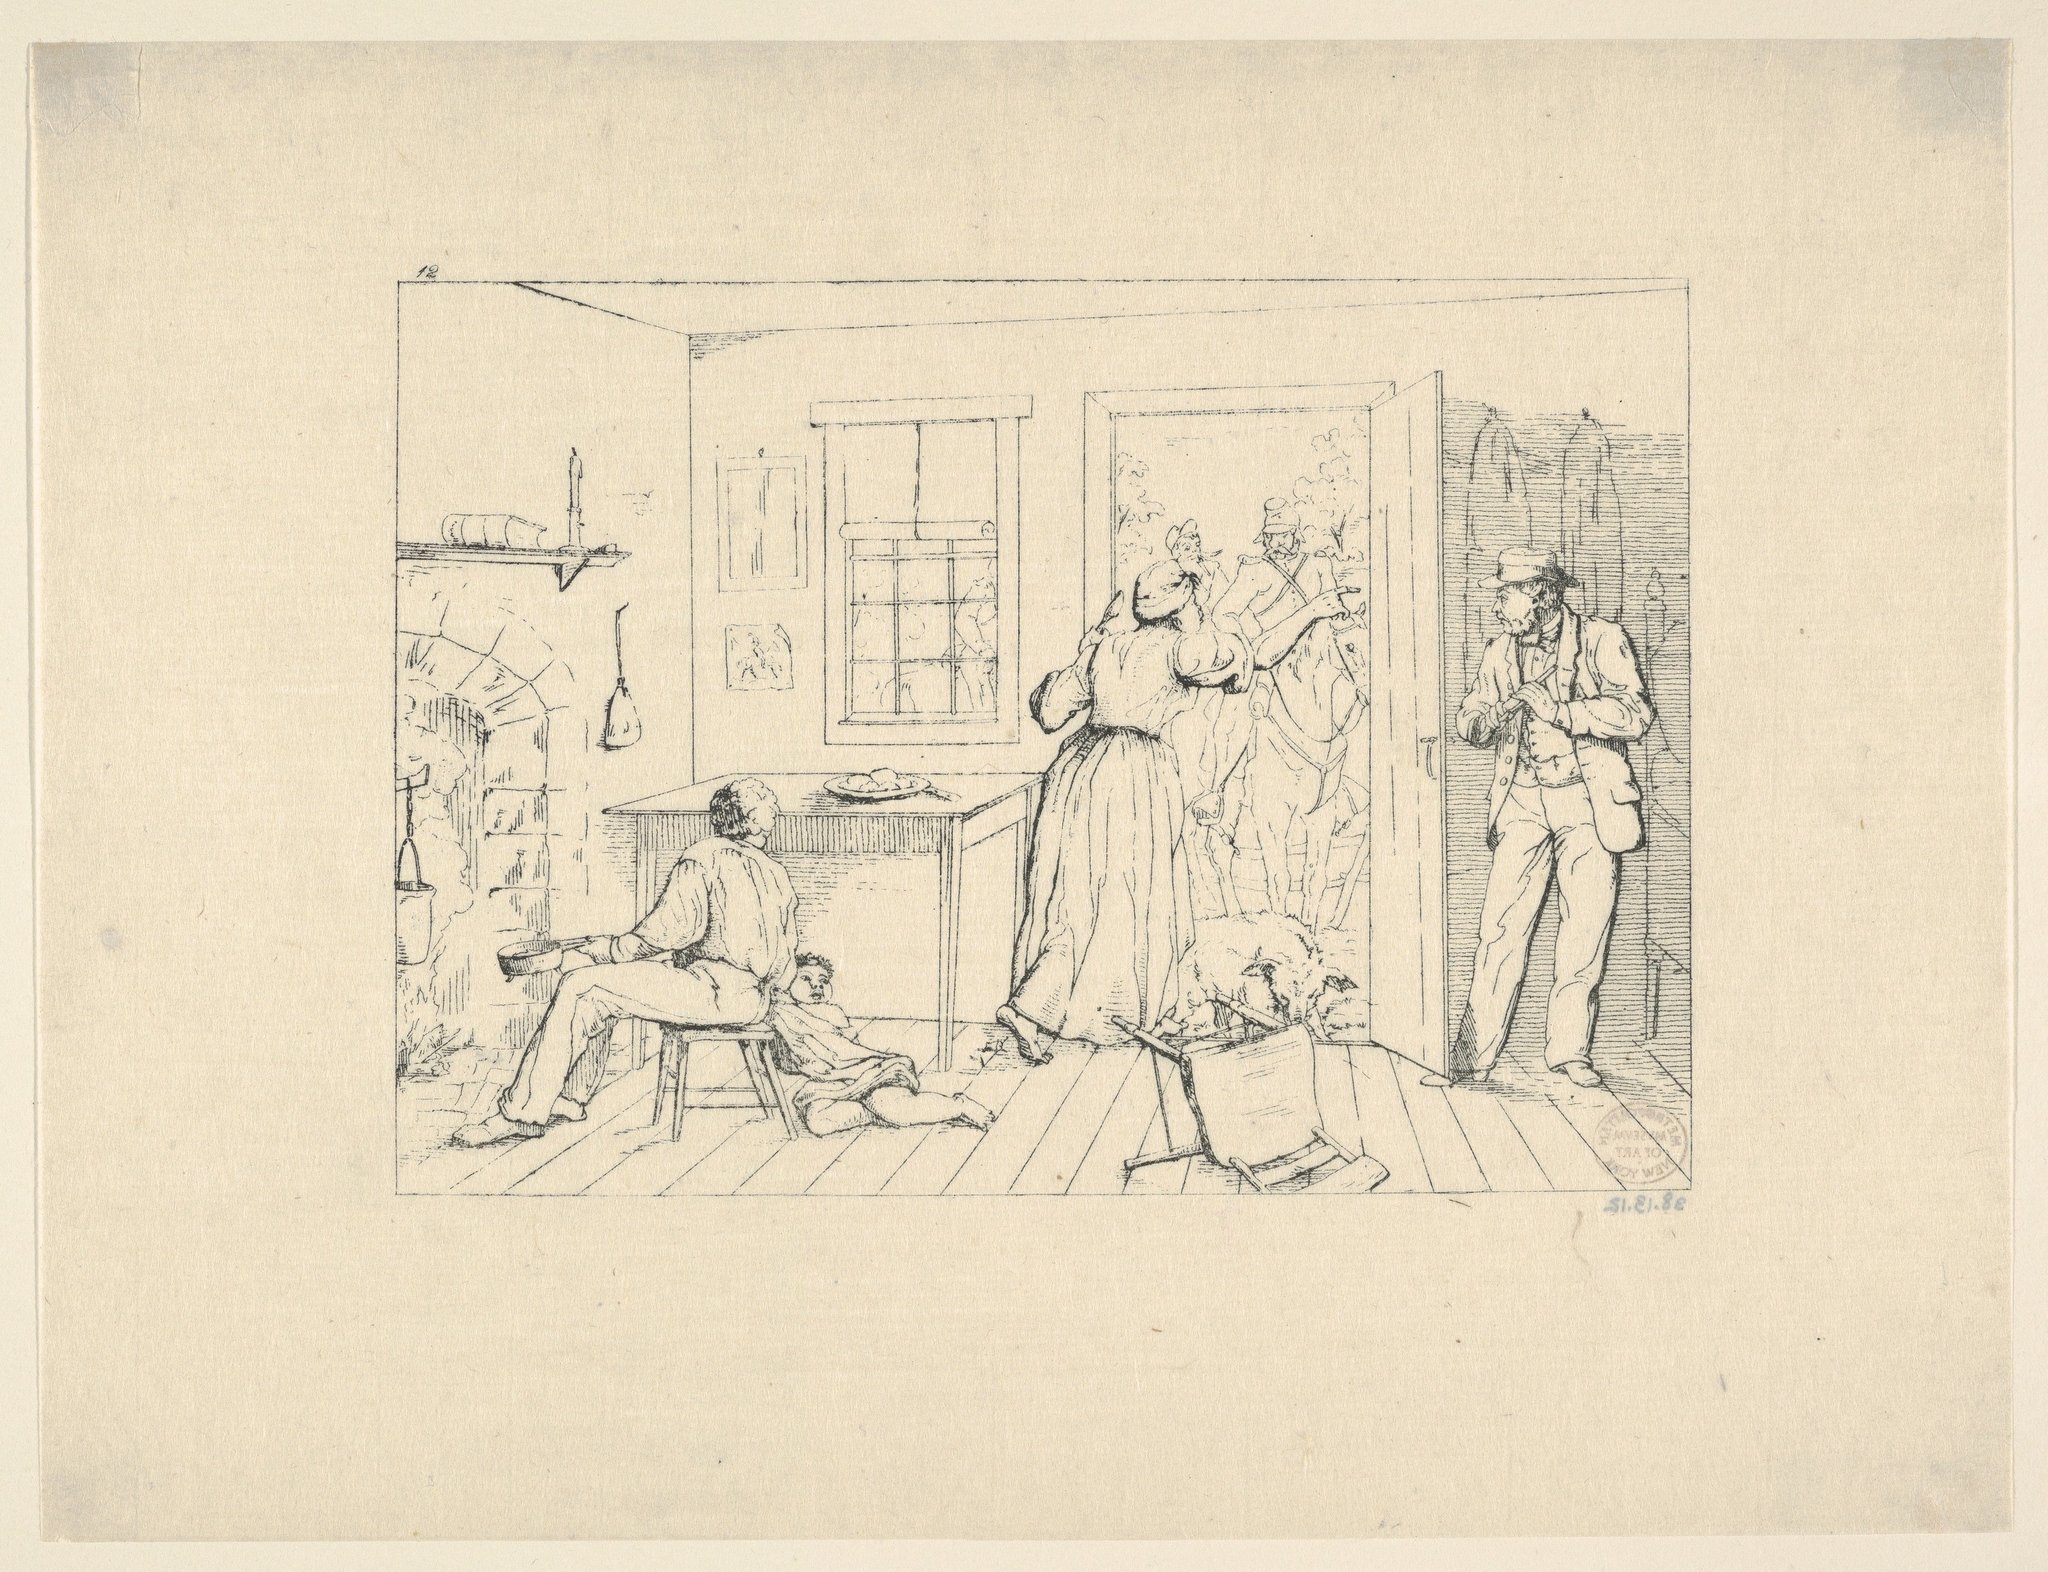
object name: print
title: Enslaved Women Concealing their Master from a Search Party (from Confederate War Etchings)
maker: adalbert john volck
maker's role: artist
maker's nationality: american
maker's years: 1828-1912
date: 1861-1863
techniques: etching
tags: american civil war,men,women,slaves